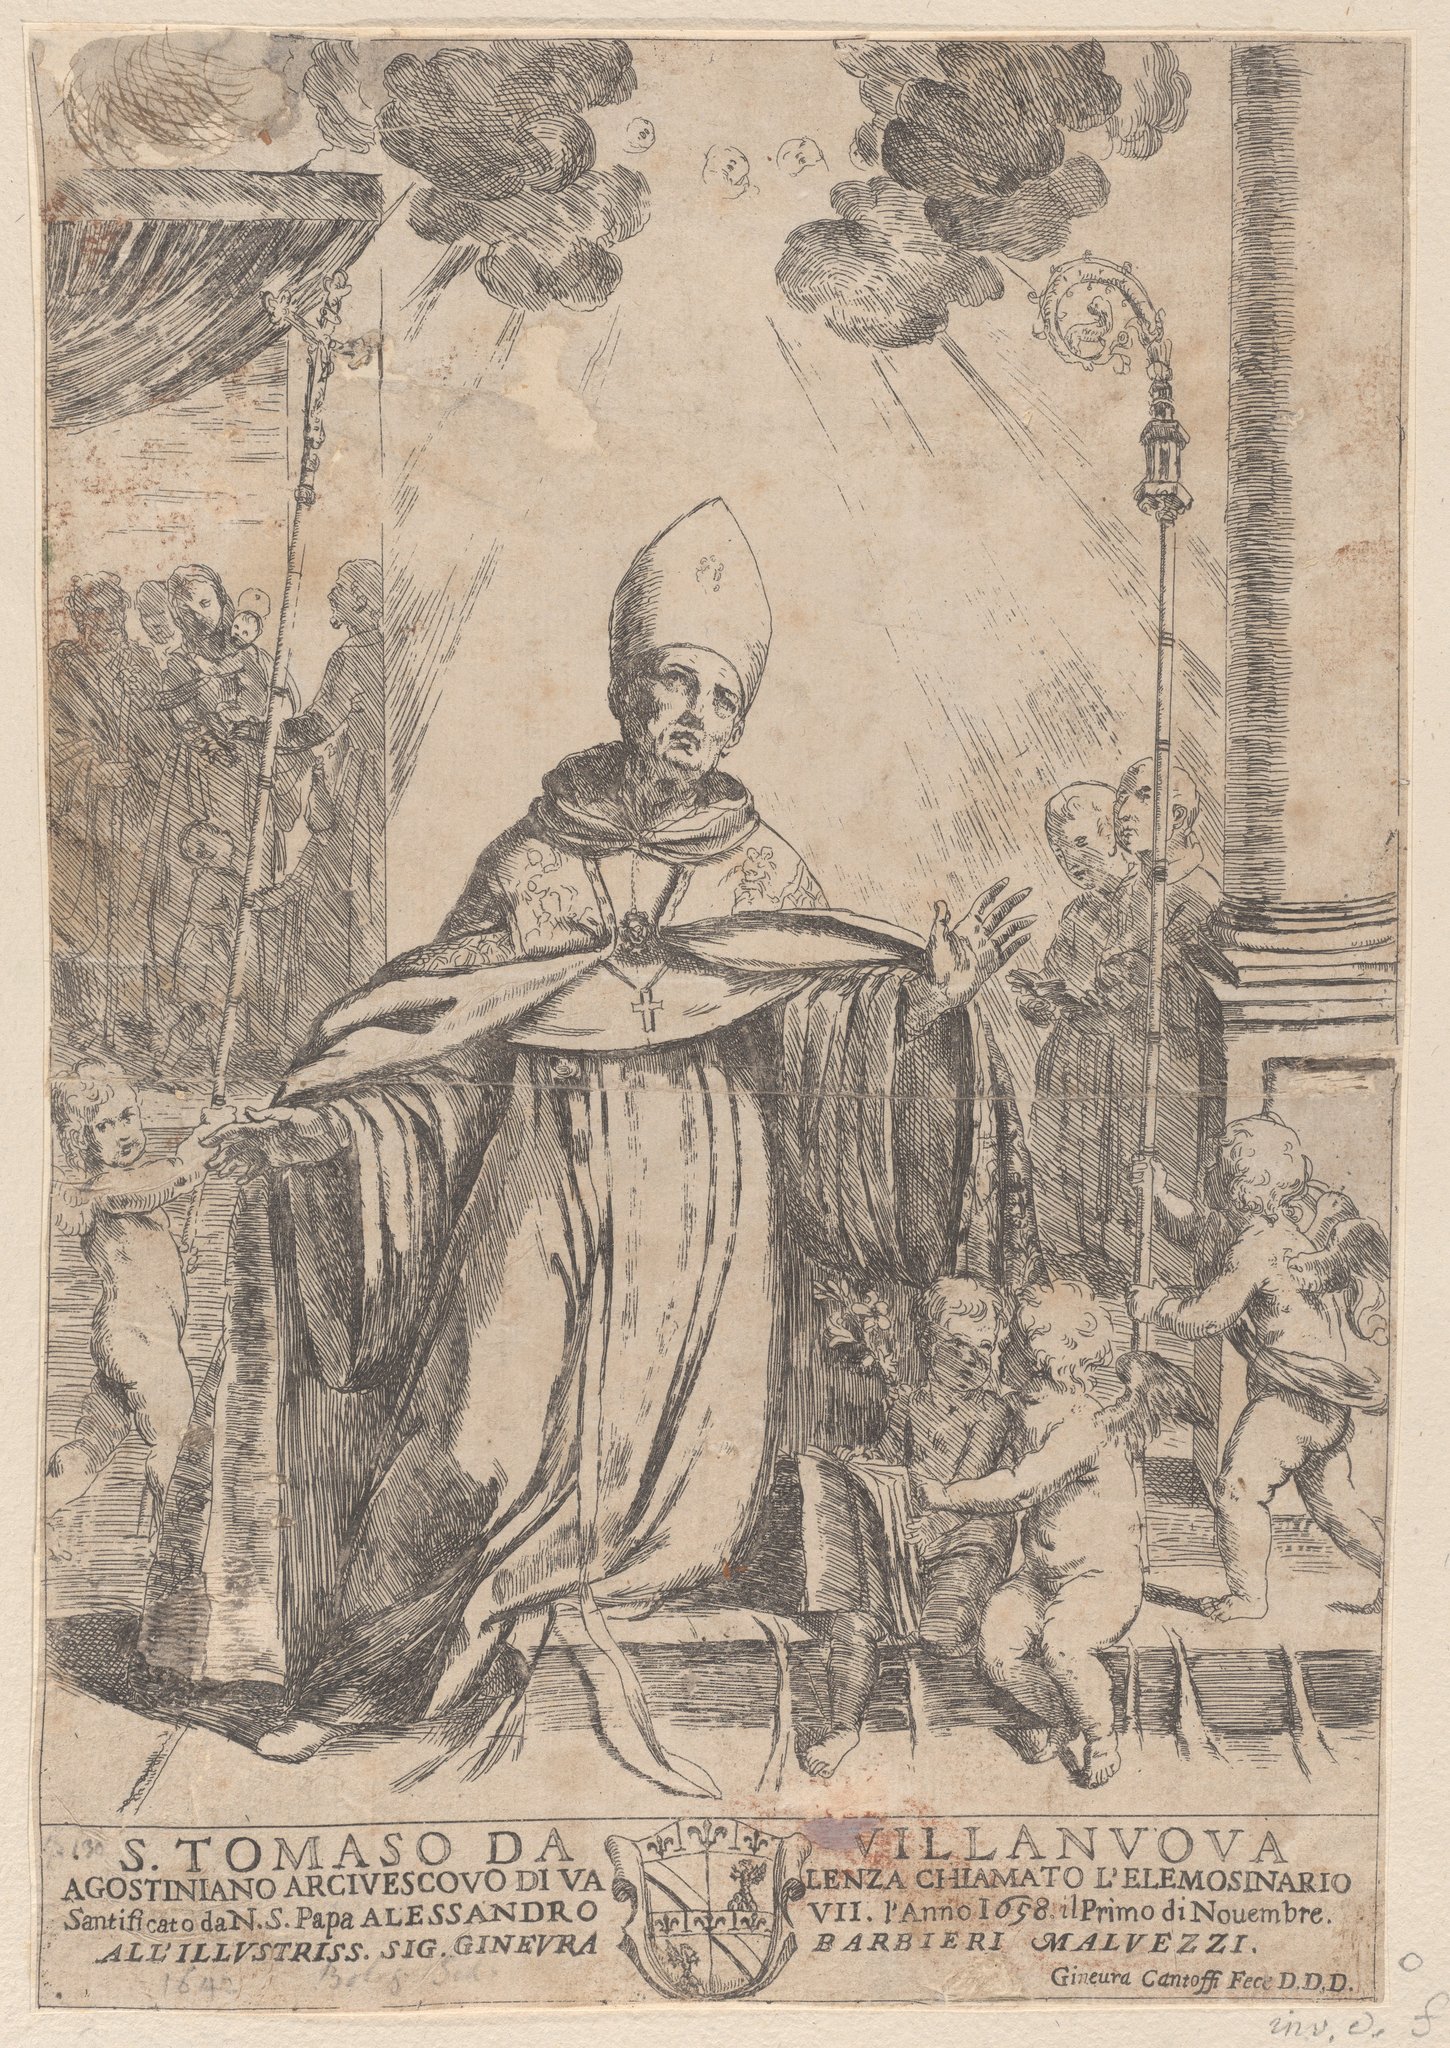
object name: print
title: Saint Thomas of Villanova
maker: ginevra cantofoli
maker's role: artist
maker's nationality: italian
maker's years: 1608-1672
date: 1658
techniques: etching